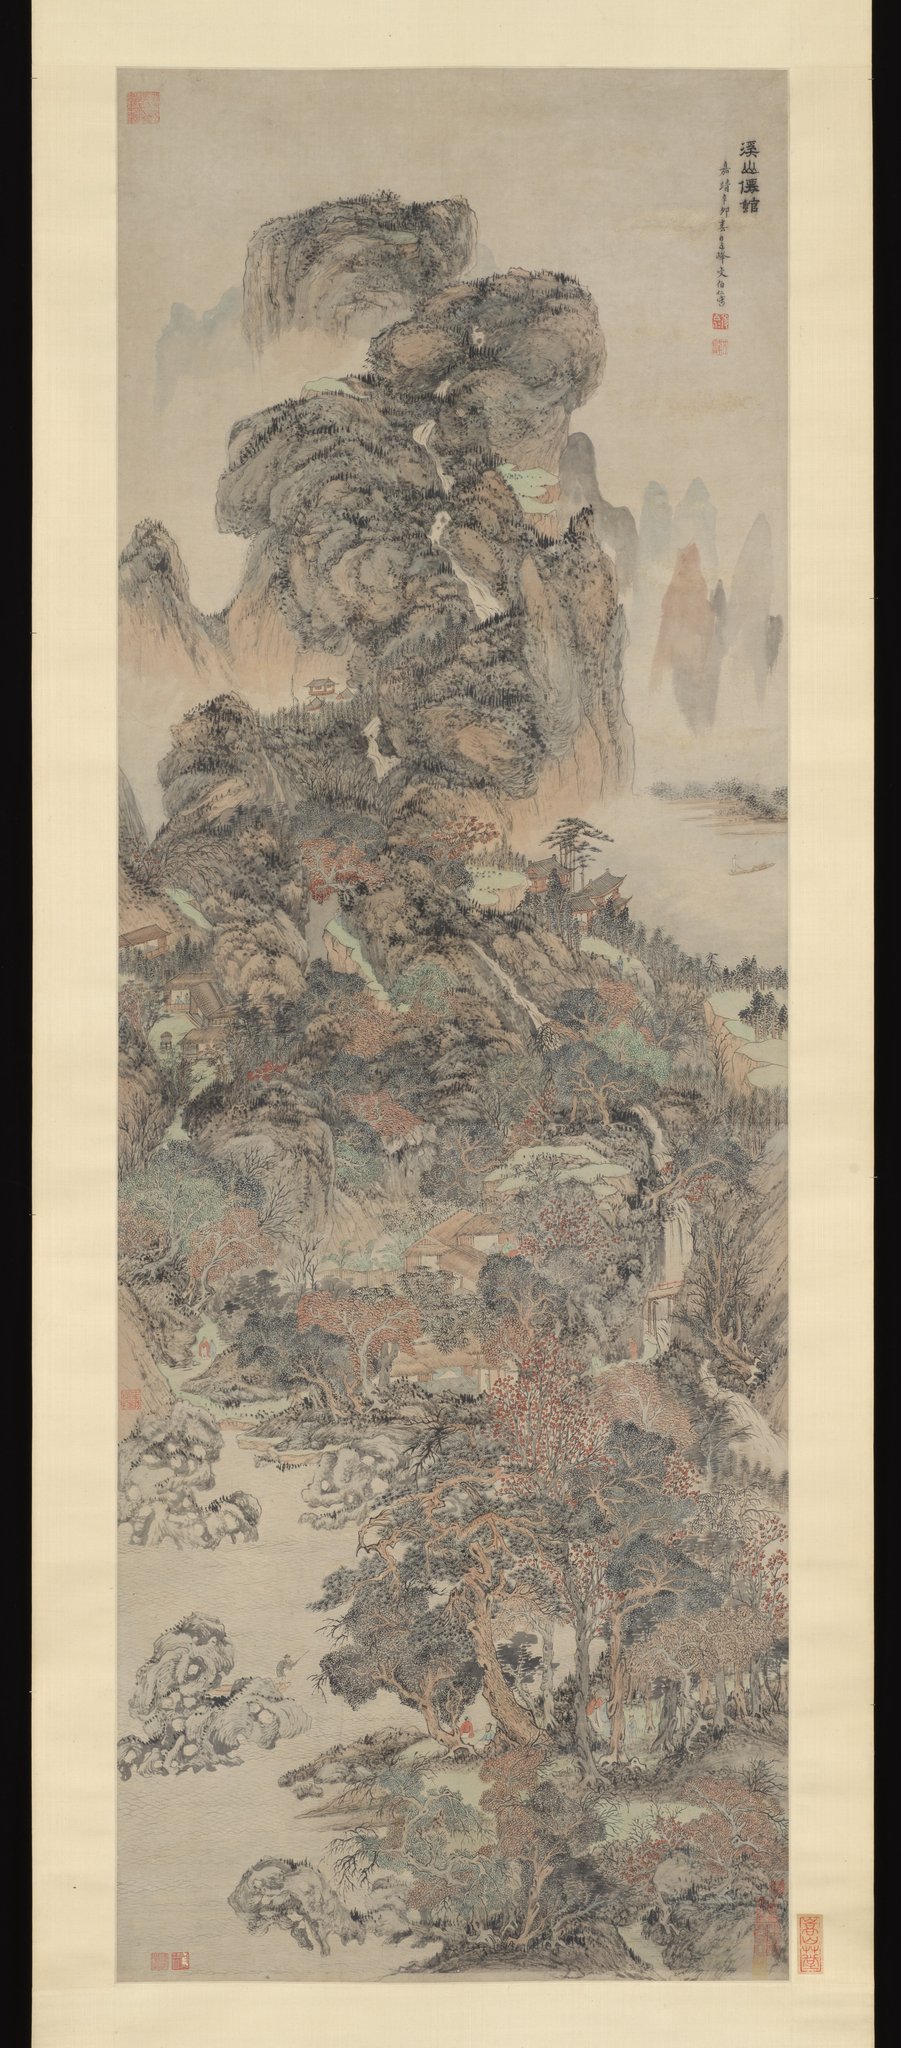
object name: hanging scroll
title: Dwellings of the Immortals Amid Streams and Mountains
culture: chinese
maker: wen boren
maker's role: artist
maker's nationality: chinese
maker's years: 1502-1575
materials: ink, paper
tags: mountains,landscapes